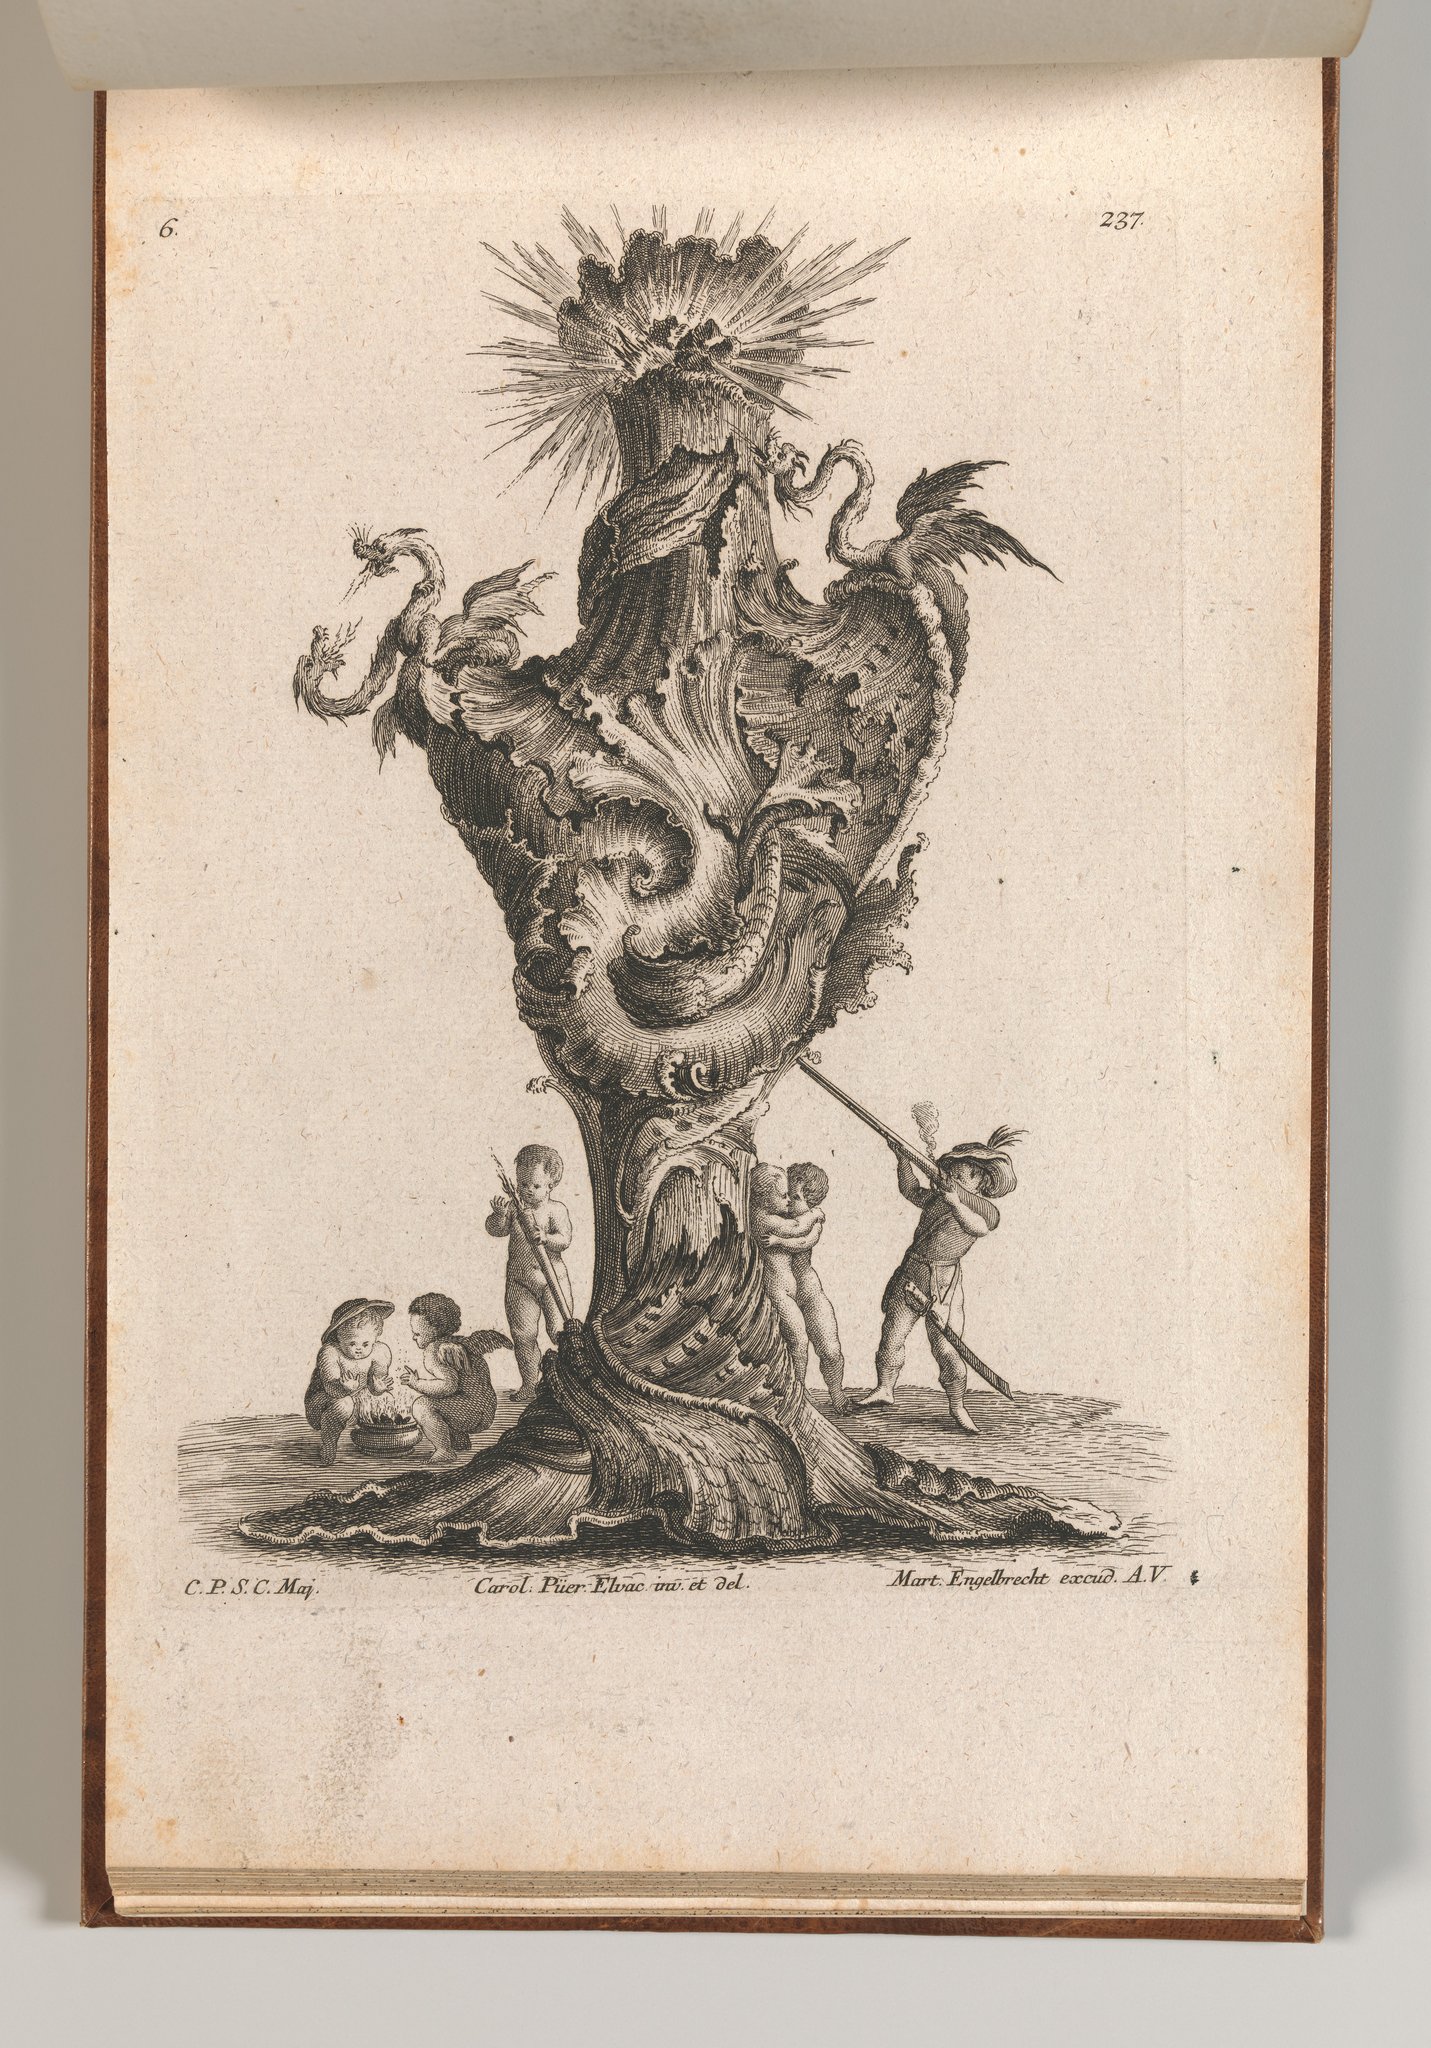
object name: album print ornament architecture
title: Design for a large Vase representing 'Fire', Plate 6 from: 'Neu inventierte Vasi auf die neueste manier'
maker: jacob gottlieb thelot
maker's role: engraver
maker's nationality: central european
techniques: etching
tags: dragons,putti,vases